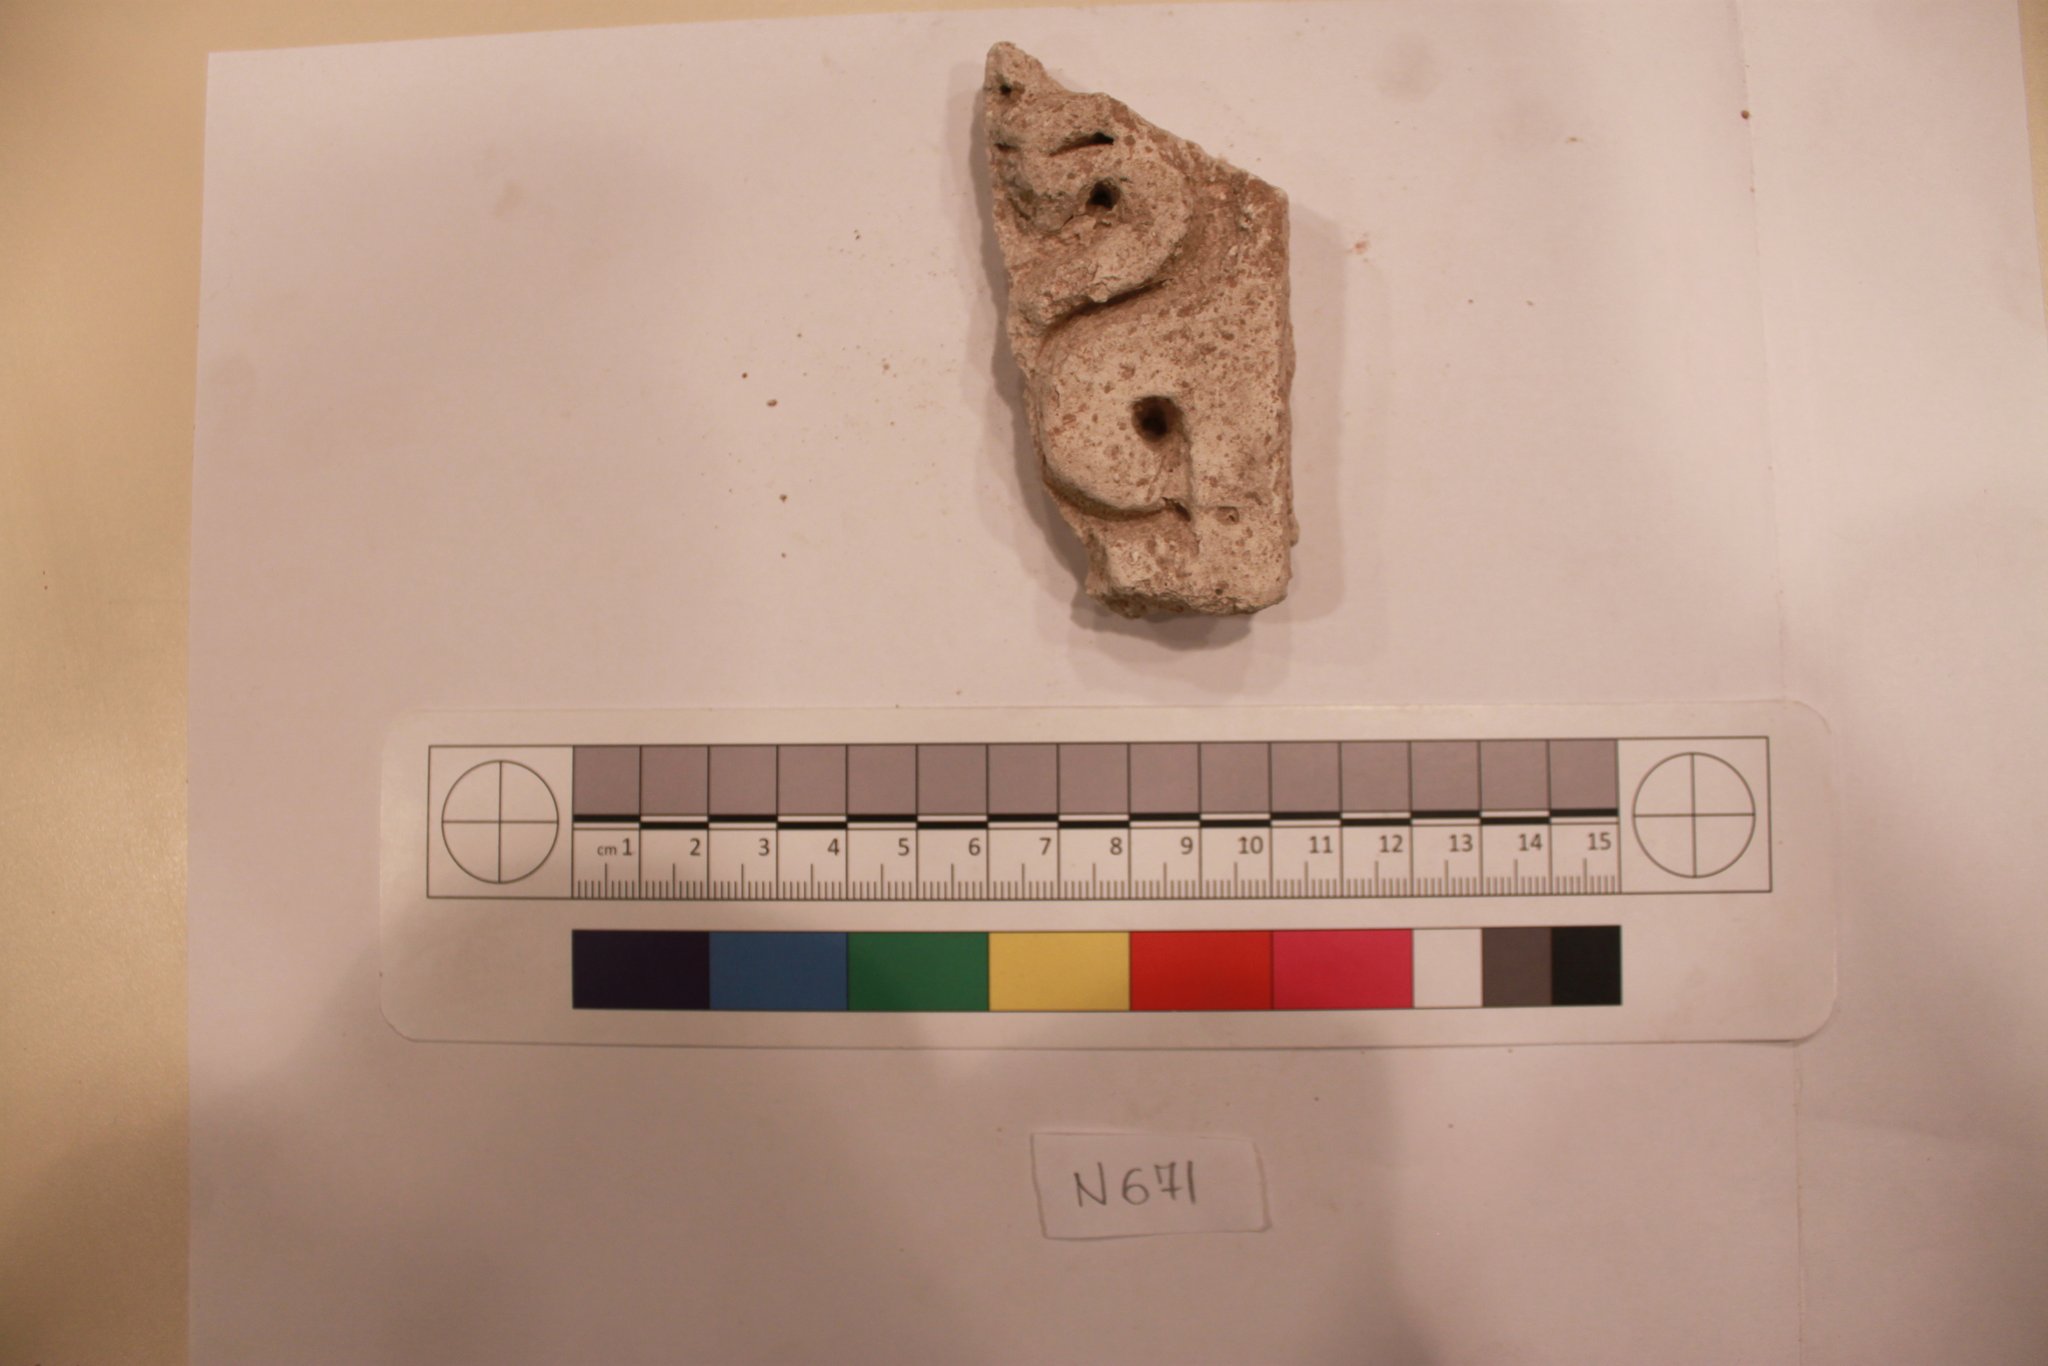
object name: fragment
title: Stucco Fragment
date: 701-1200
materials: plaster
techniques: carving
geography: iran